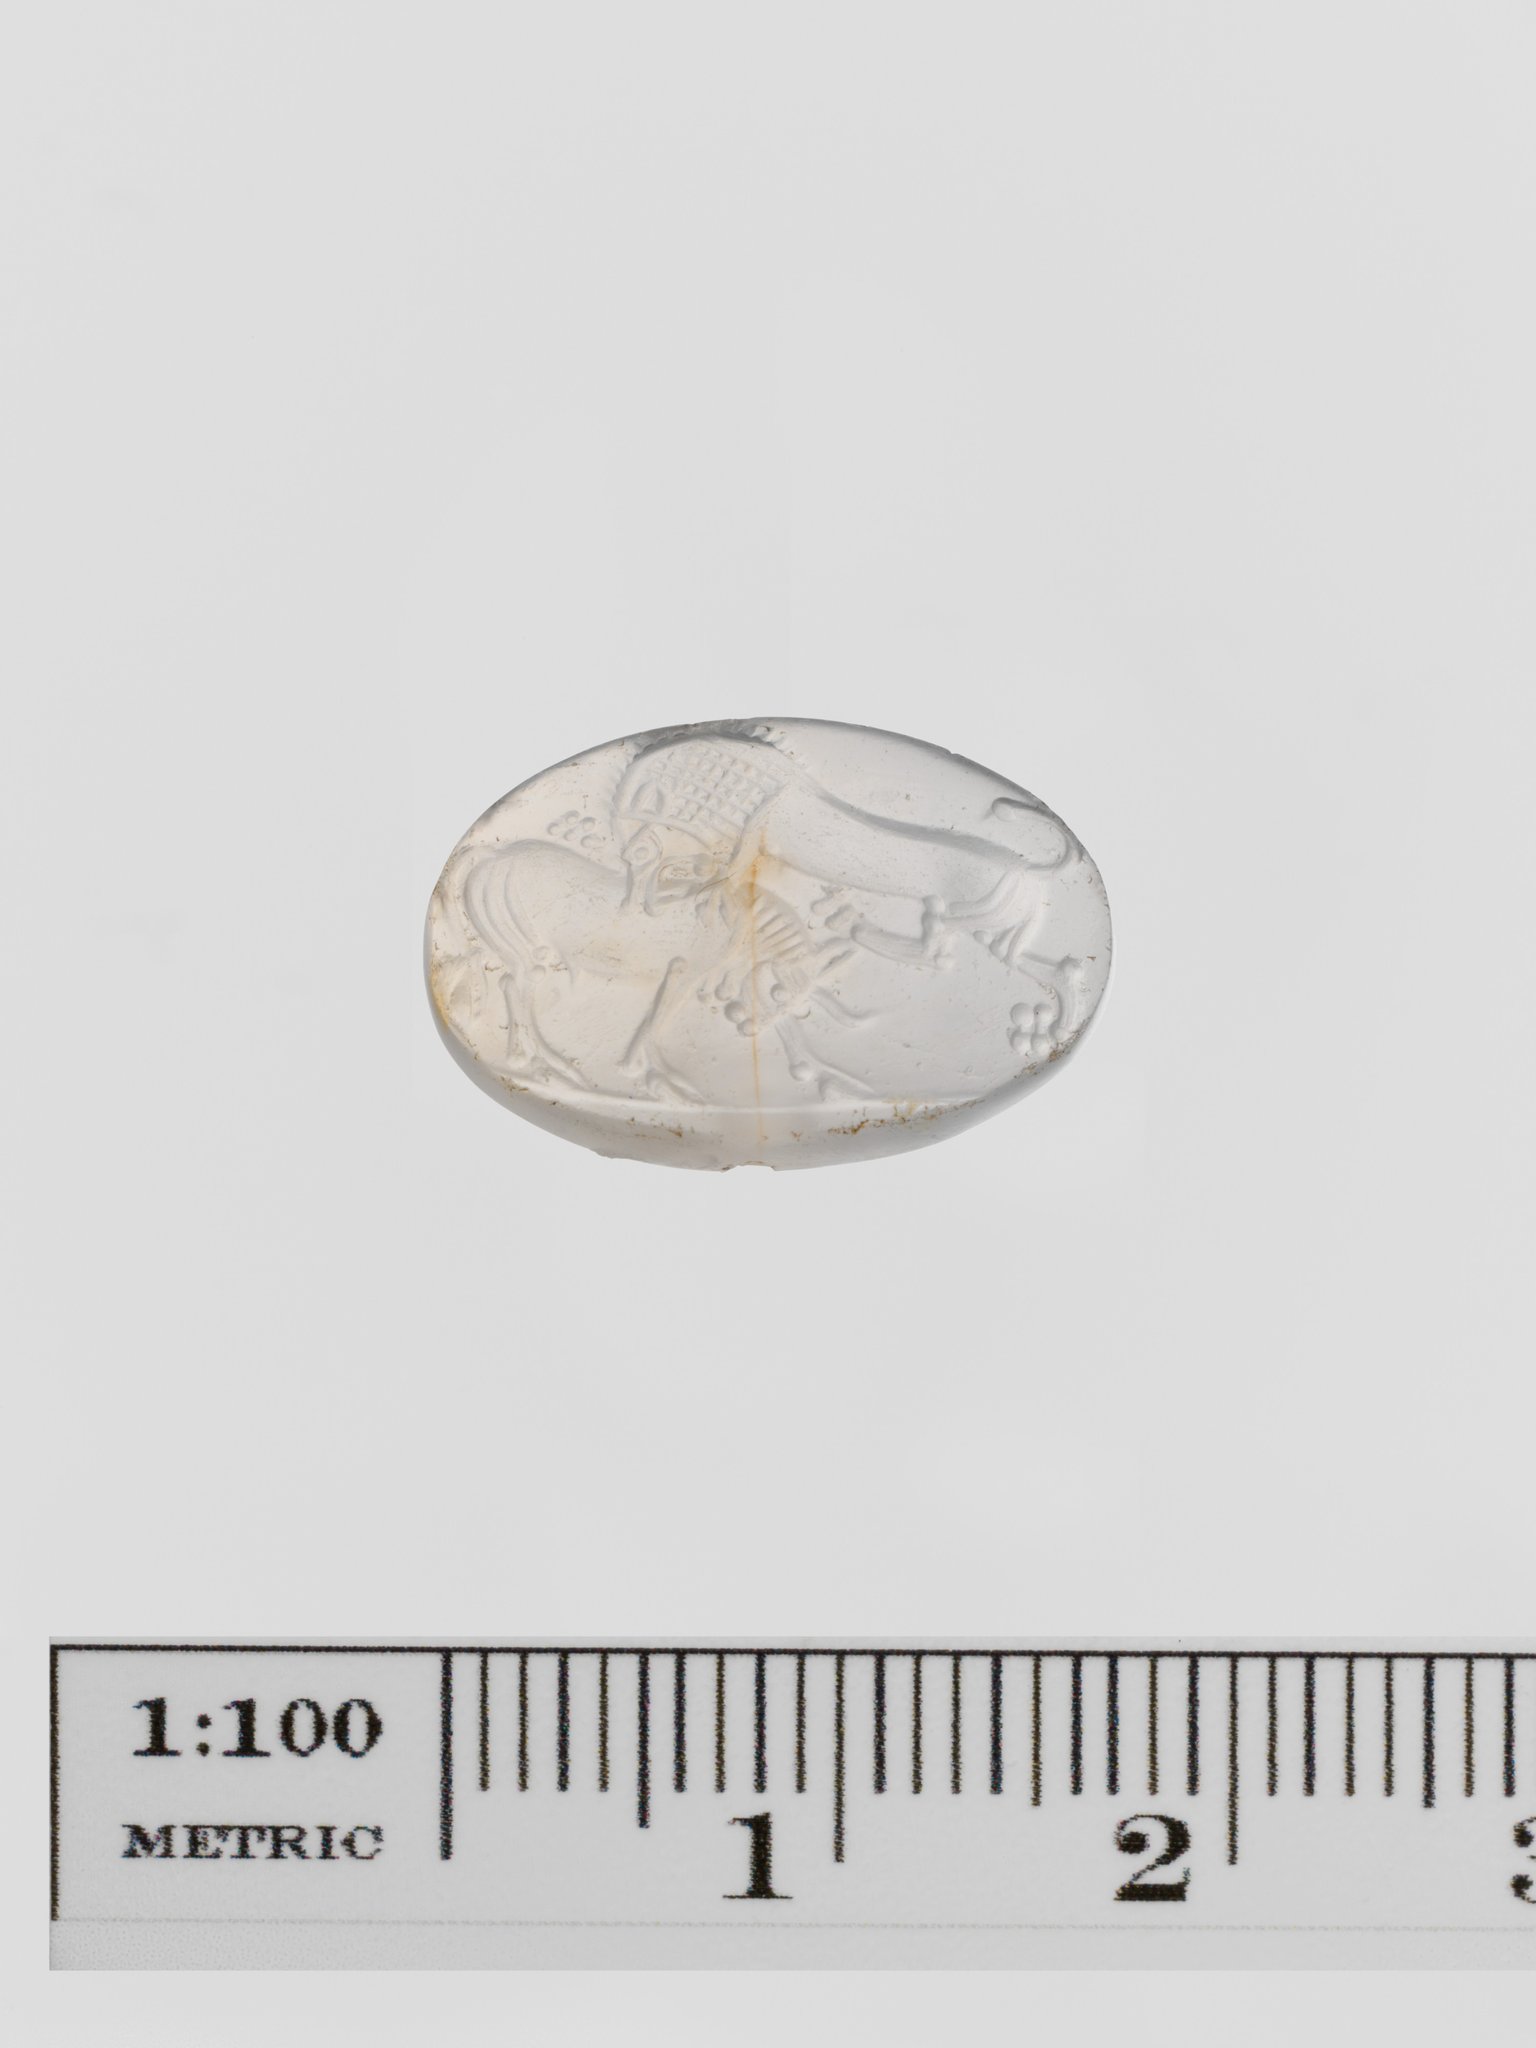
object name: intaglio, conoid cut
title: Chalcedony conoid seal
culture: greek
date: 534-501 BCE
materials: stone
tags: bulls,lions